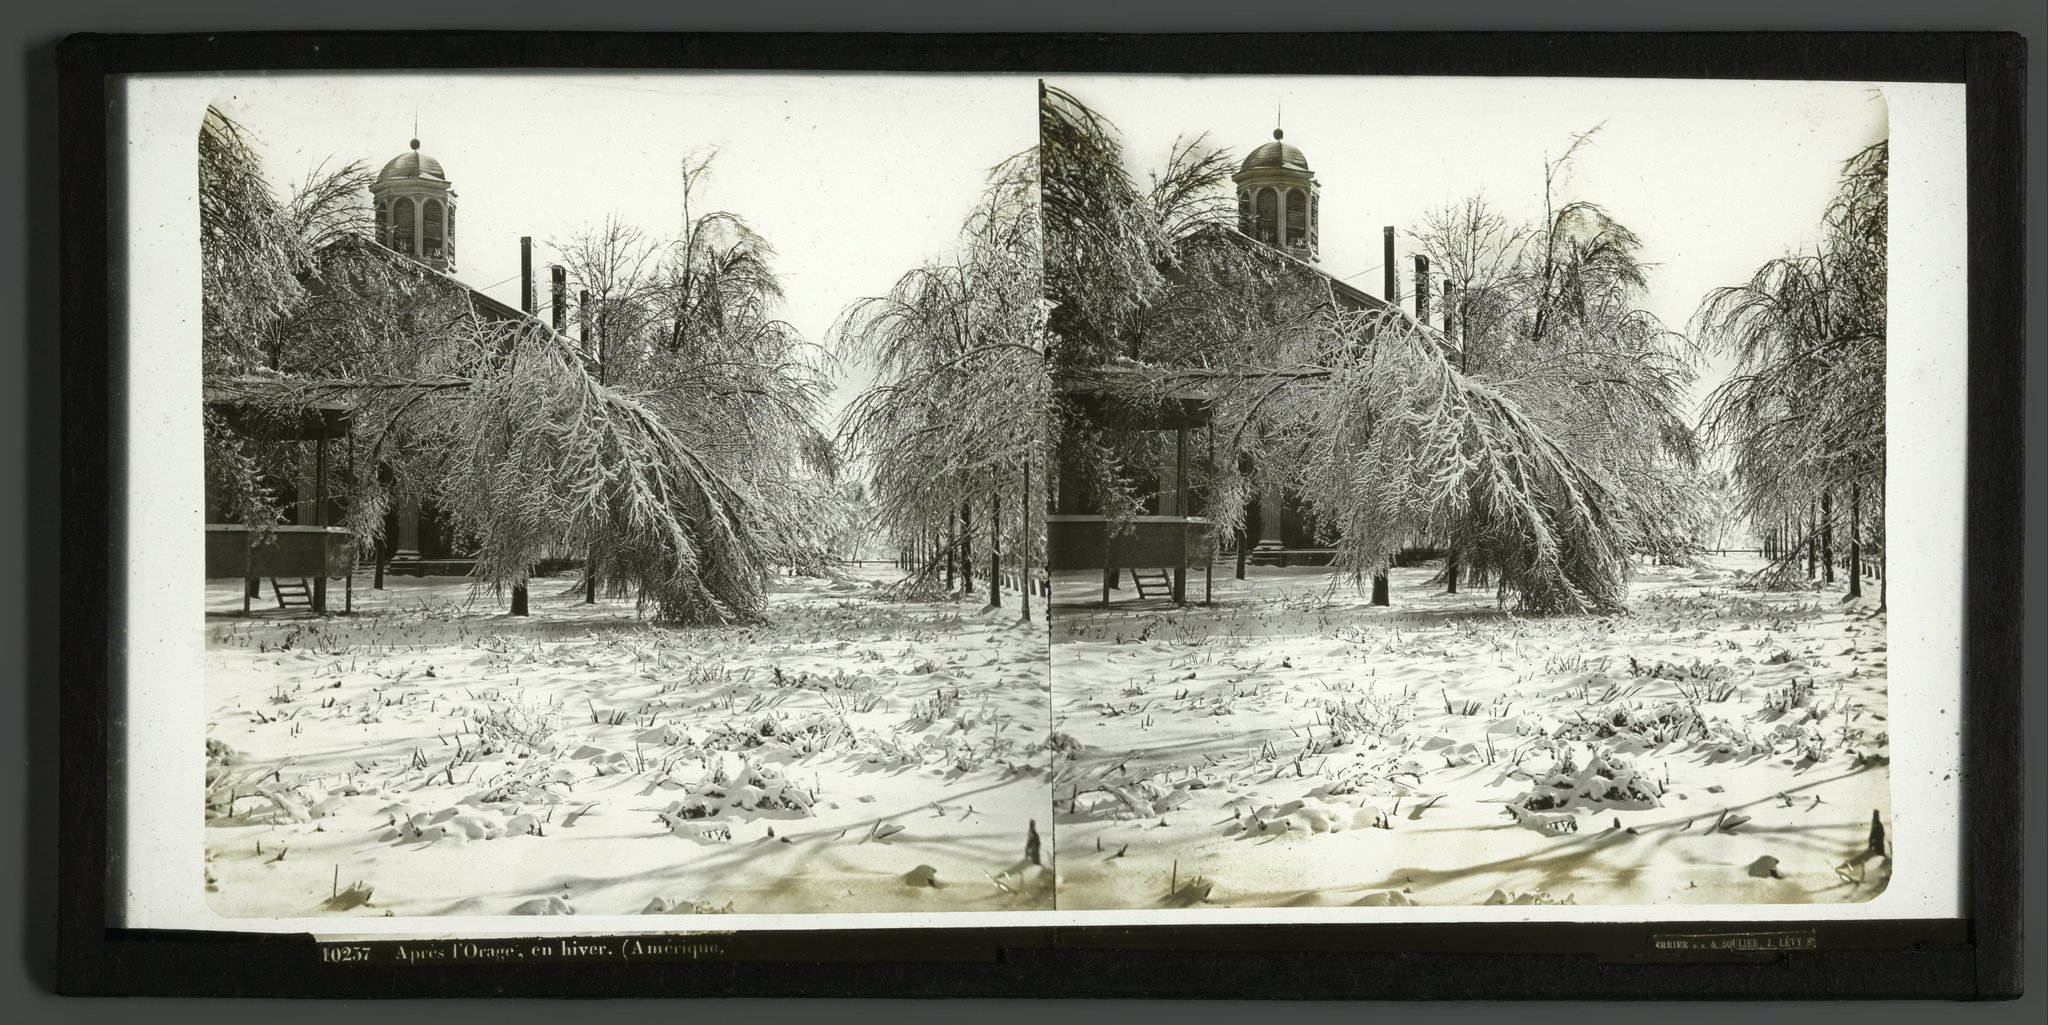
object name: stereoscopic photograph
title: Gezicht op een orangerie in de winter in Noord-Amerika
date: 1864-1873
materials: glass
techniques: slide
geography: united states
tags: greenhouse, orangery, united states of america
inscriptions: number: ‘10257’